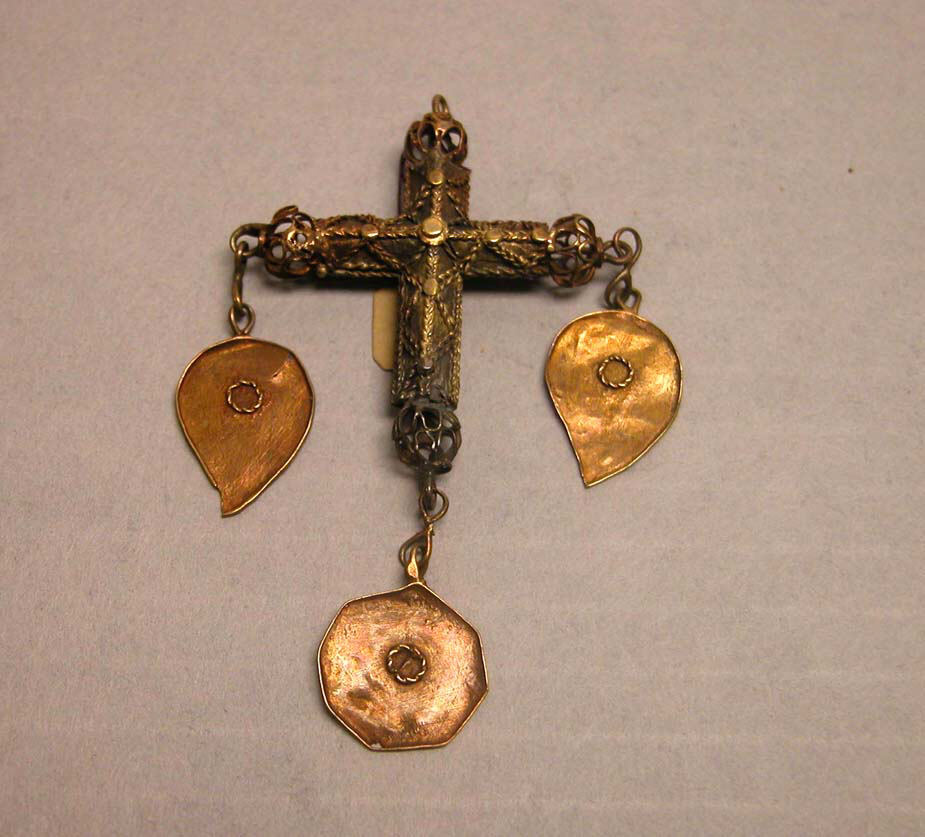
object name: pendant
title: Cross Pendant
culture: filipino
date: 1601-1900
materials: gold